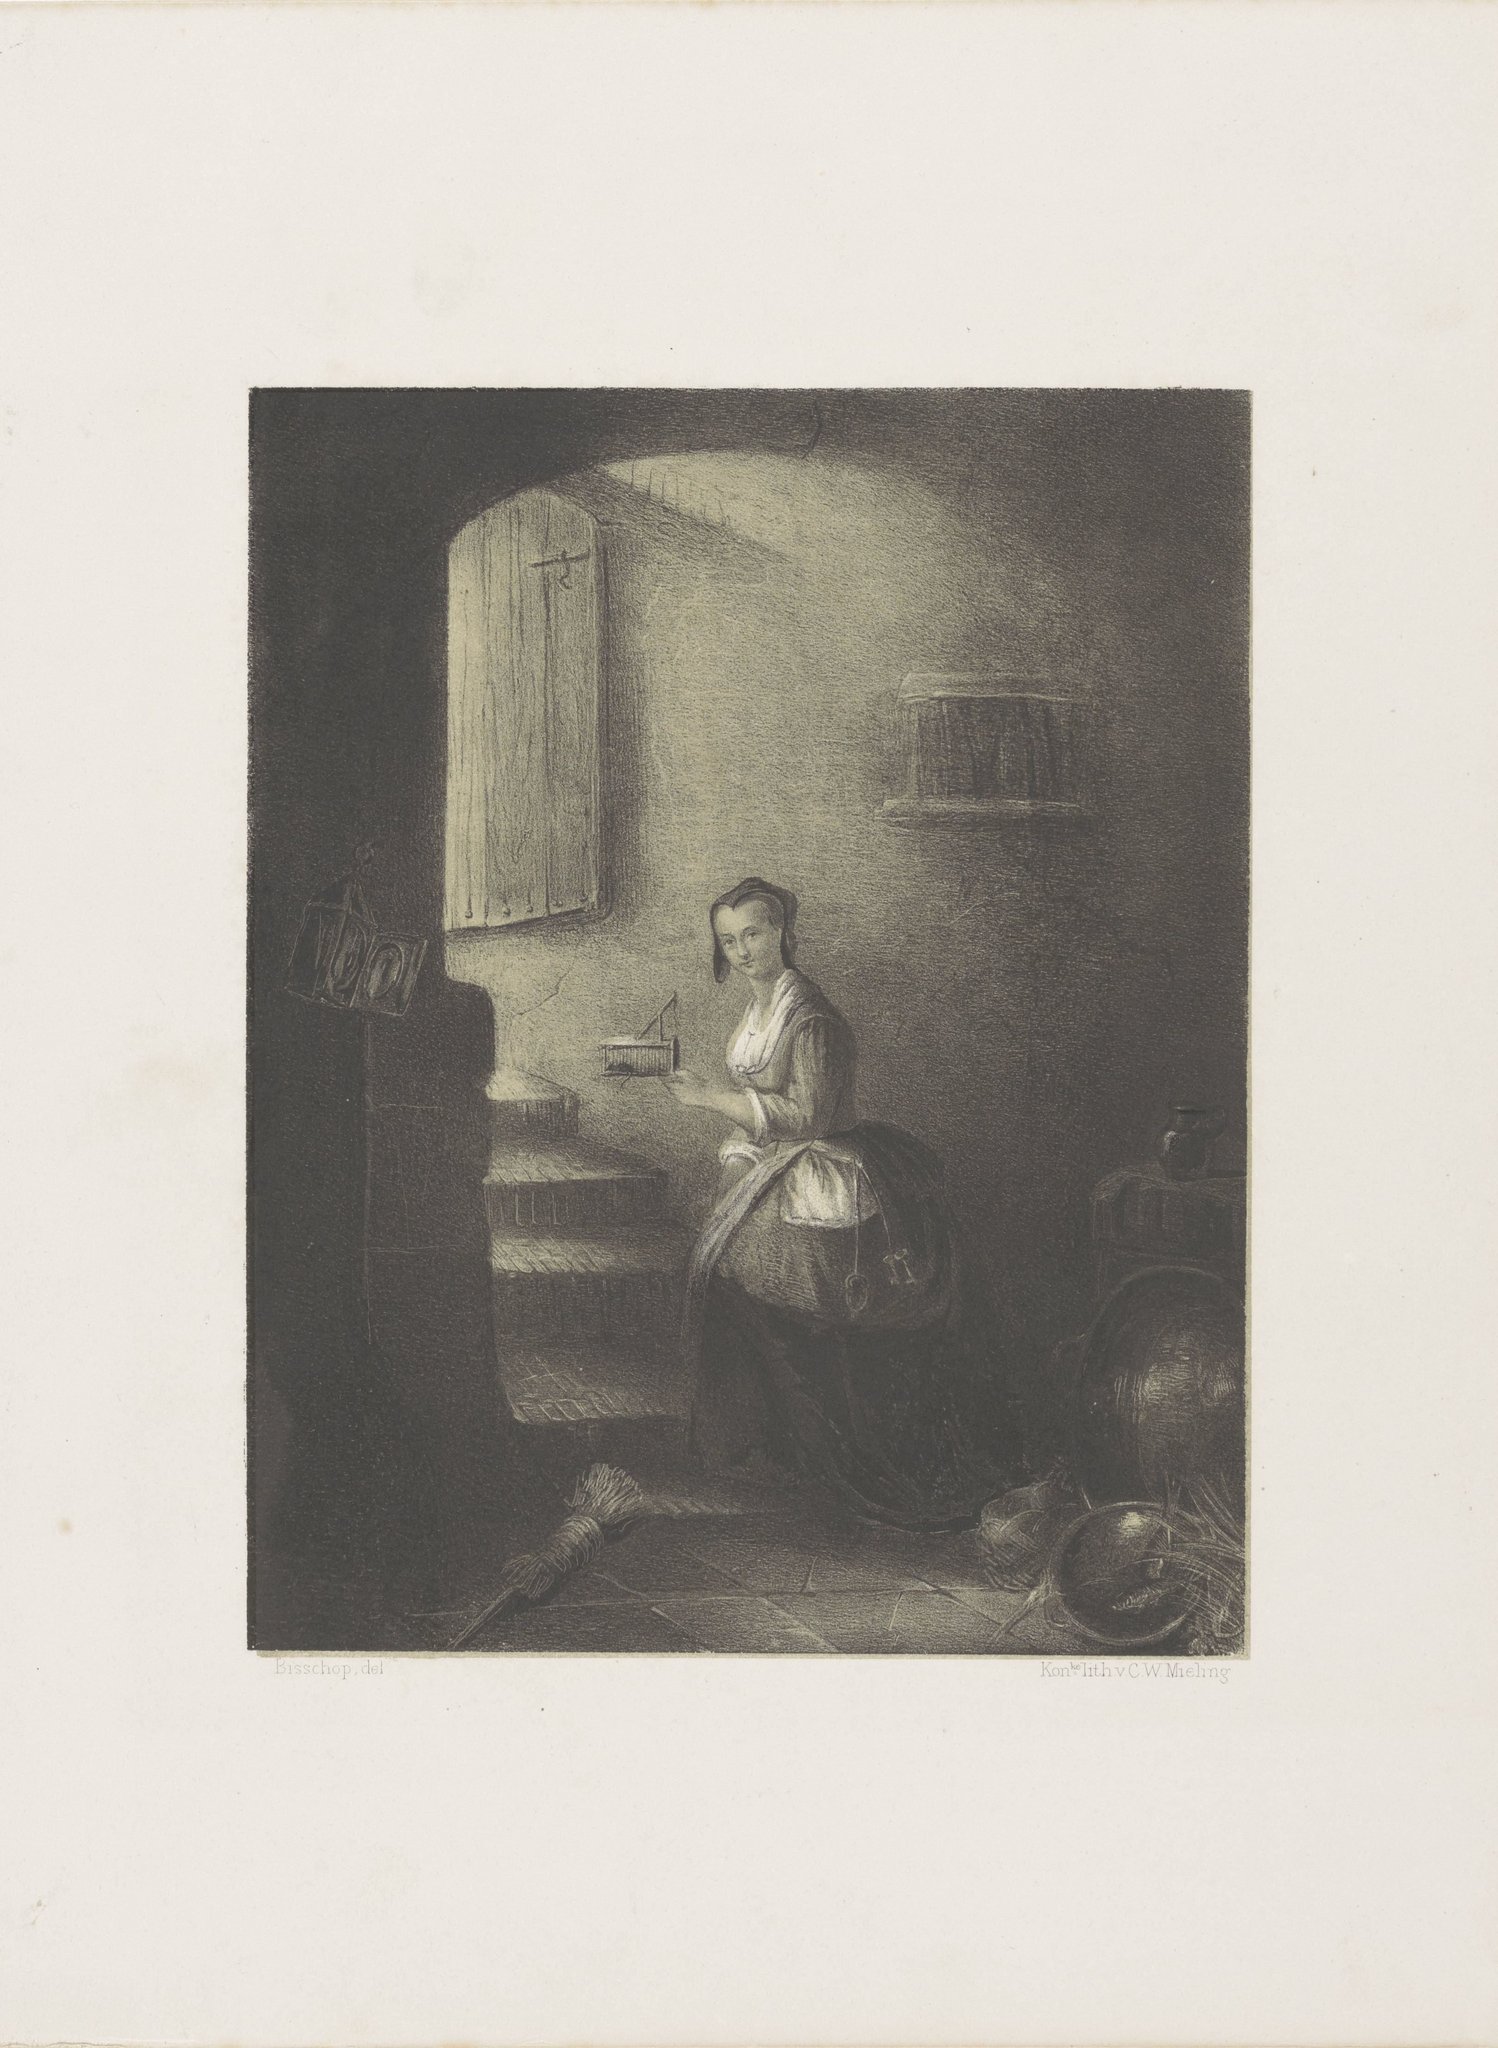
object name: print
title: Vrouw met muizenval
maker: christoffel bisschop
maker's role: draughtsman, print maker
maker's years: 1828-1904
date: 1838-1904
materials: paper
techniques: tone lithography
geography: netherlands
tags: mouse trap, (household) utensils and implements (with name), basement, cellar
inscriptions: collector's mark: Lugt 2228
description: De vrouw loopt de trap van een kelder op. Aan haar rok hangen twee sleutels. In haar handen draagt zij een muizenval met daarin een muis. Op de grond en achter haar liggen een bezem, pannen en stro.